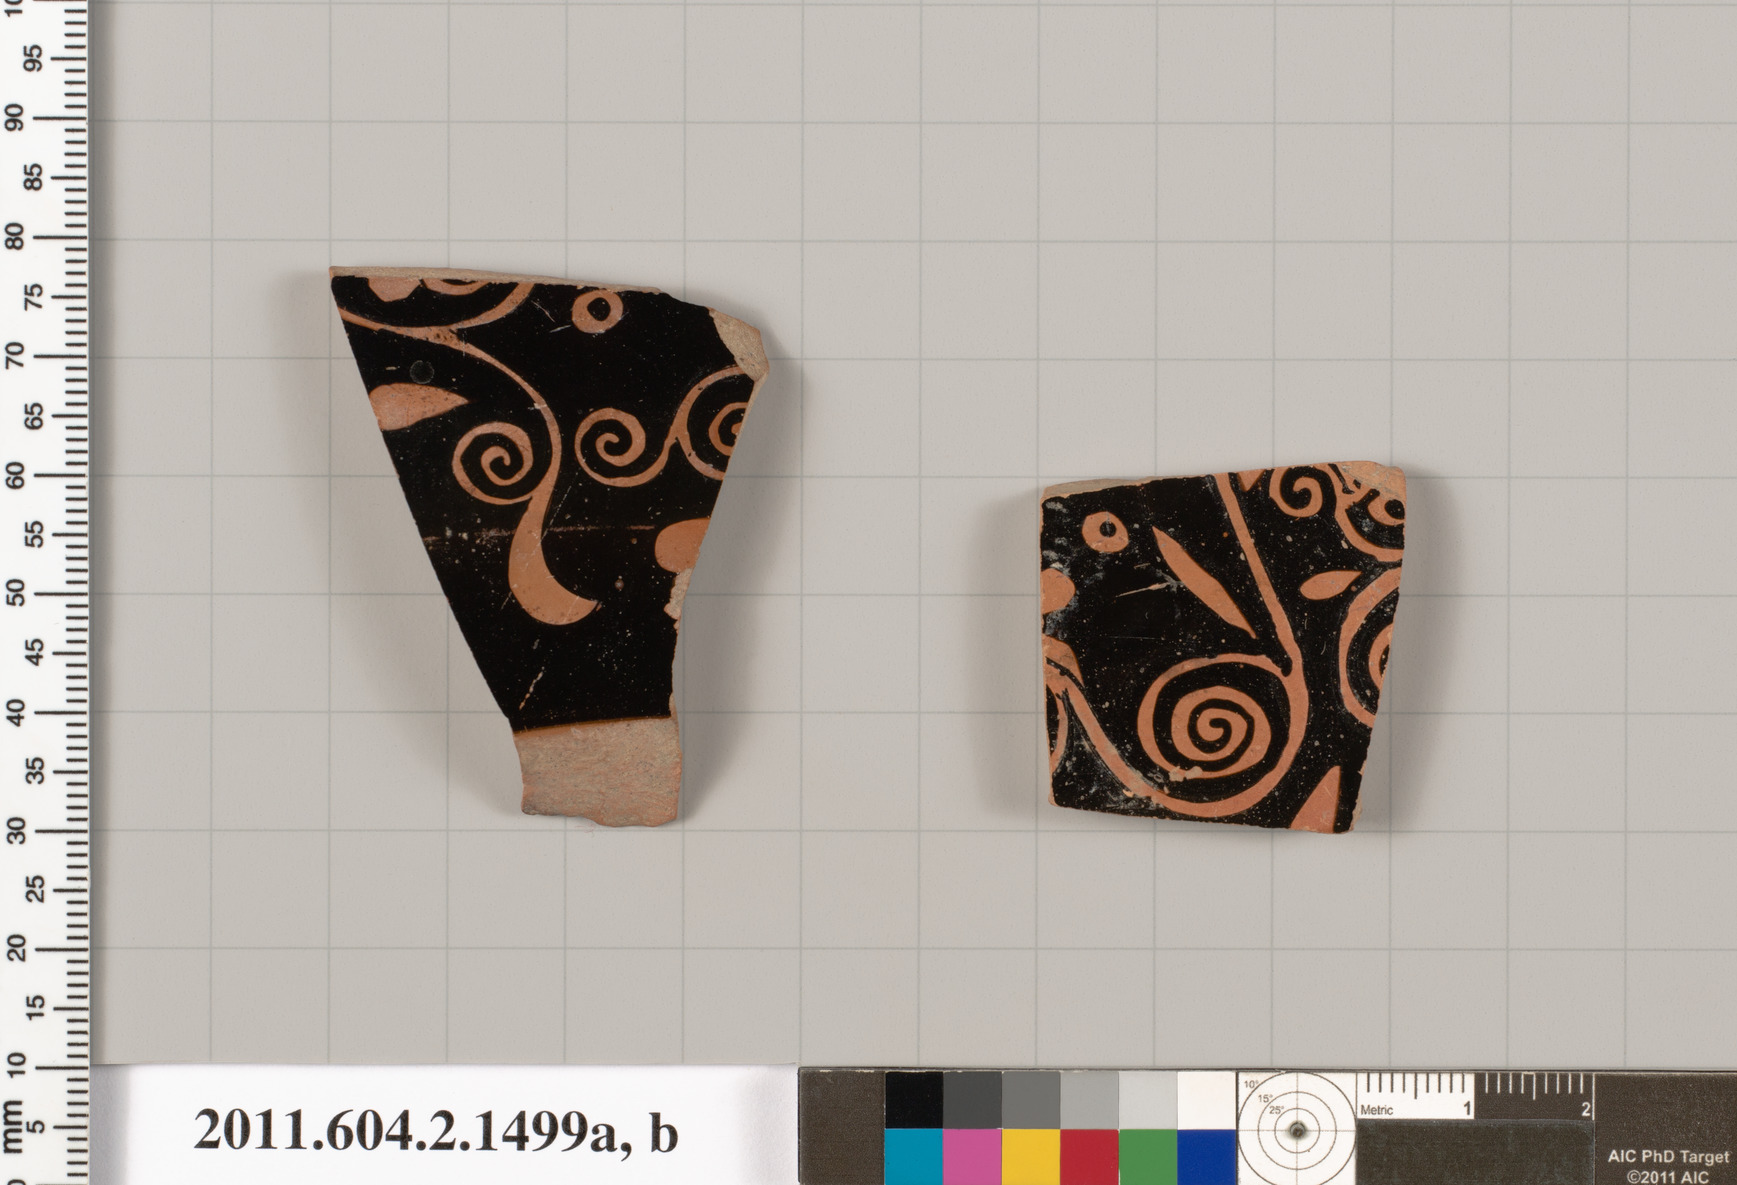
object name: skyphos fragment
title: Terracotta fragments of skyphoi (deep drinking cups)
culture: greek, attic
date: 475-440 BCE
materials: terracotta